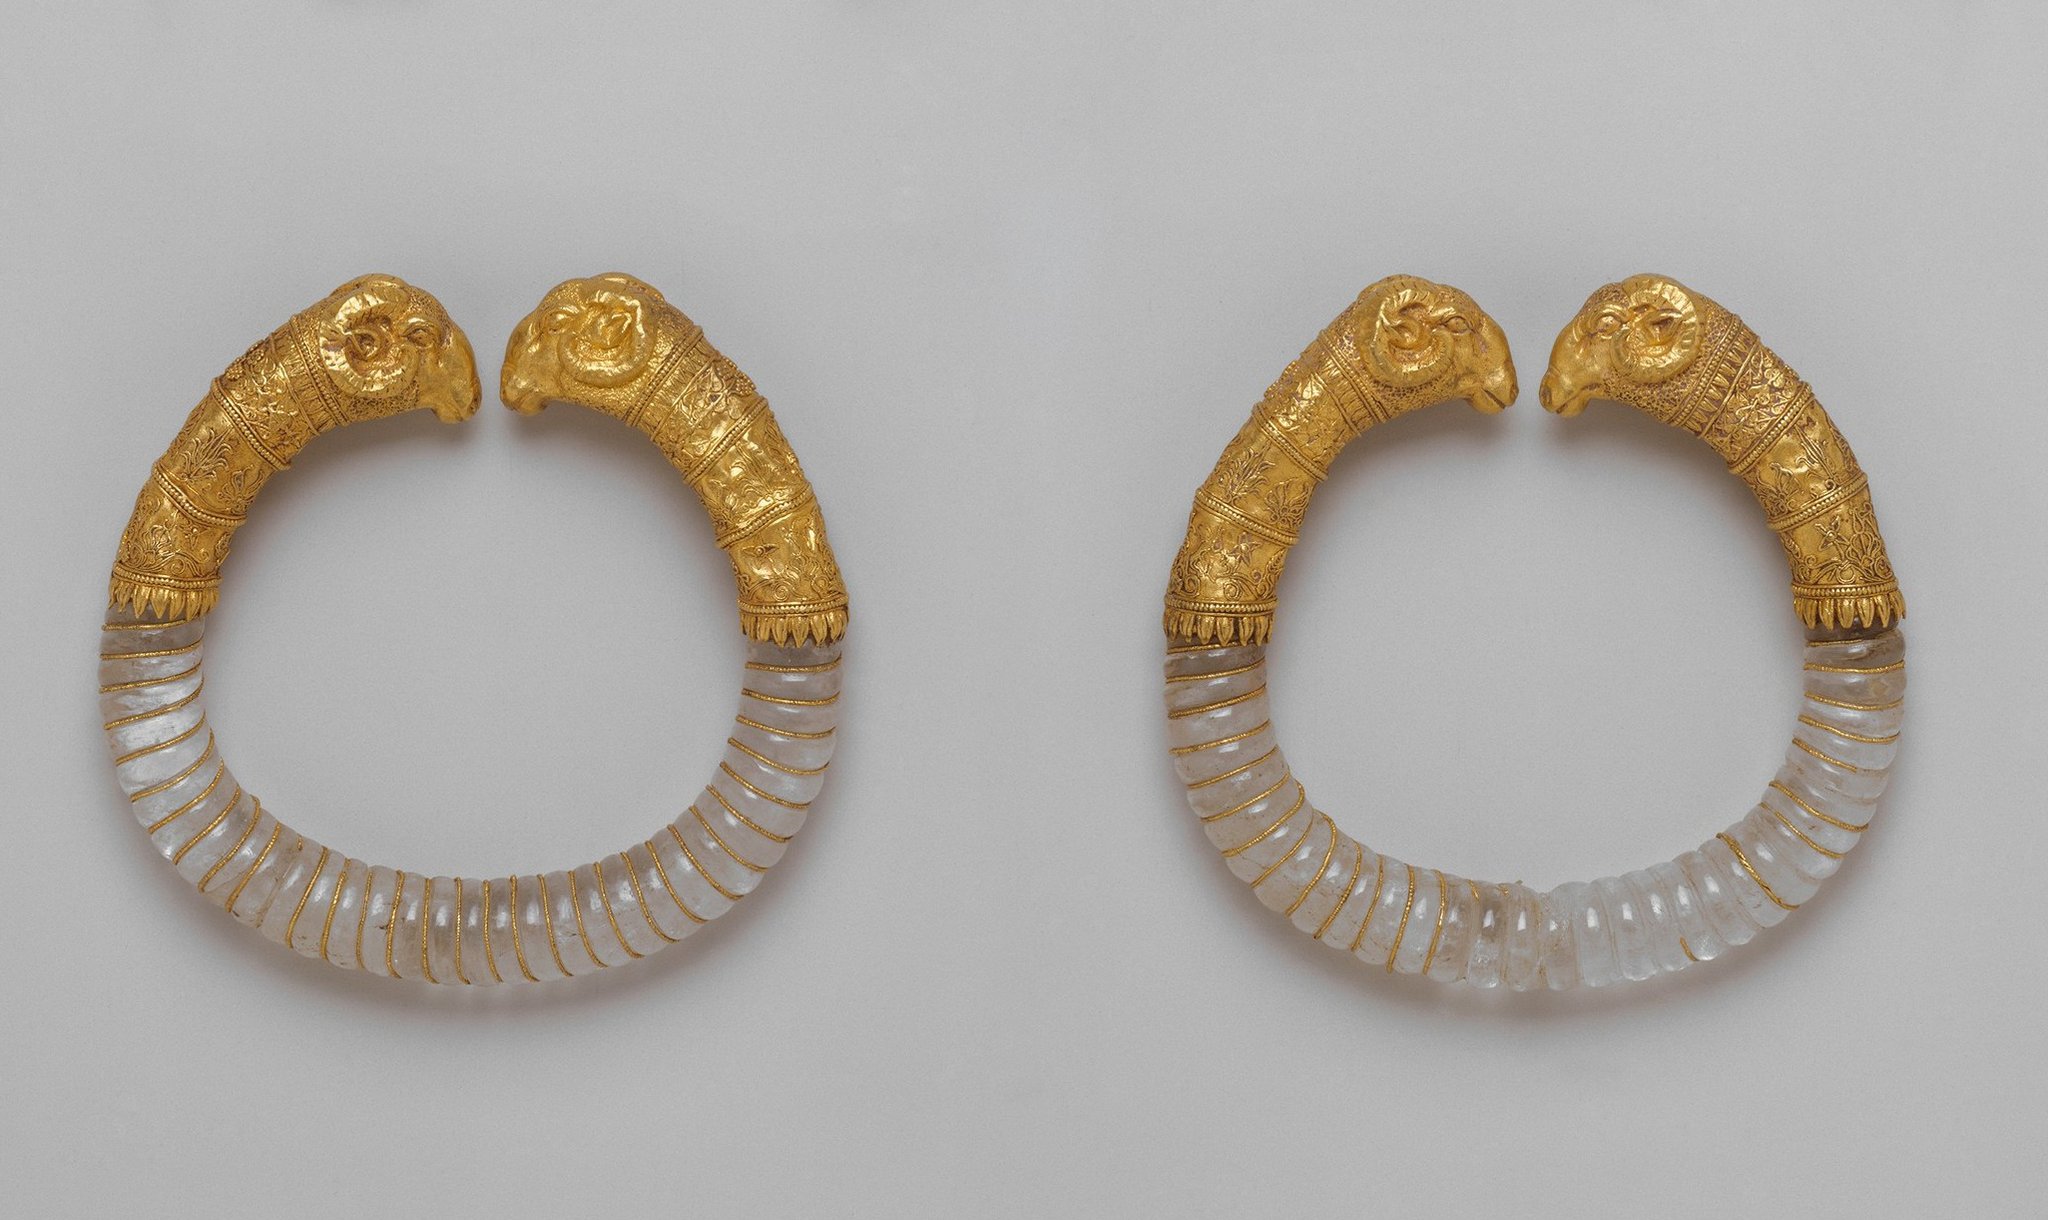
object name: bracelet with rams' head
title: Pair of bracelets with rock crystal hoops and gold rams' heads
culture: greek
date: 330-300 BCE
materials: gold, quartz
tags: rams